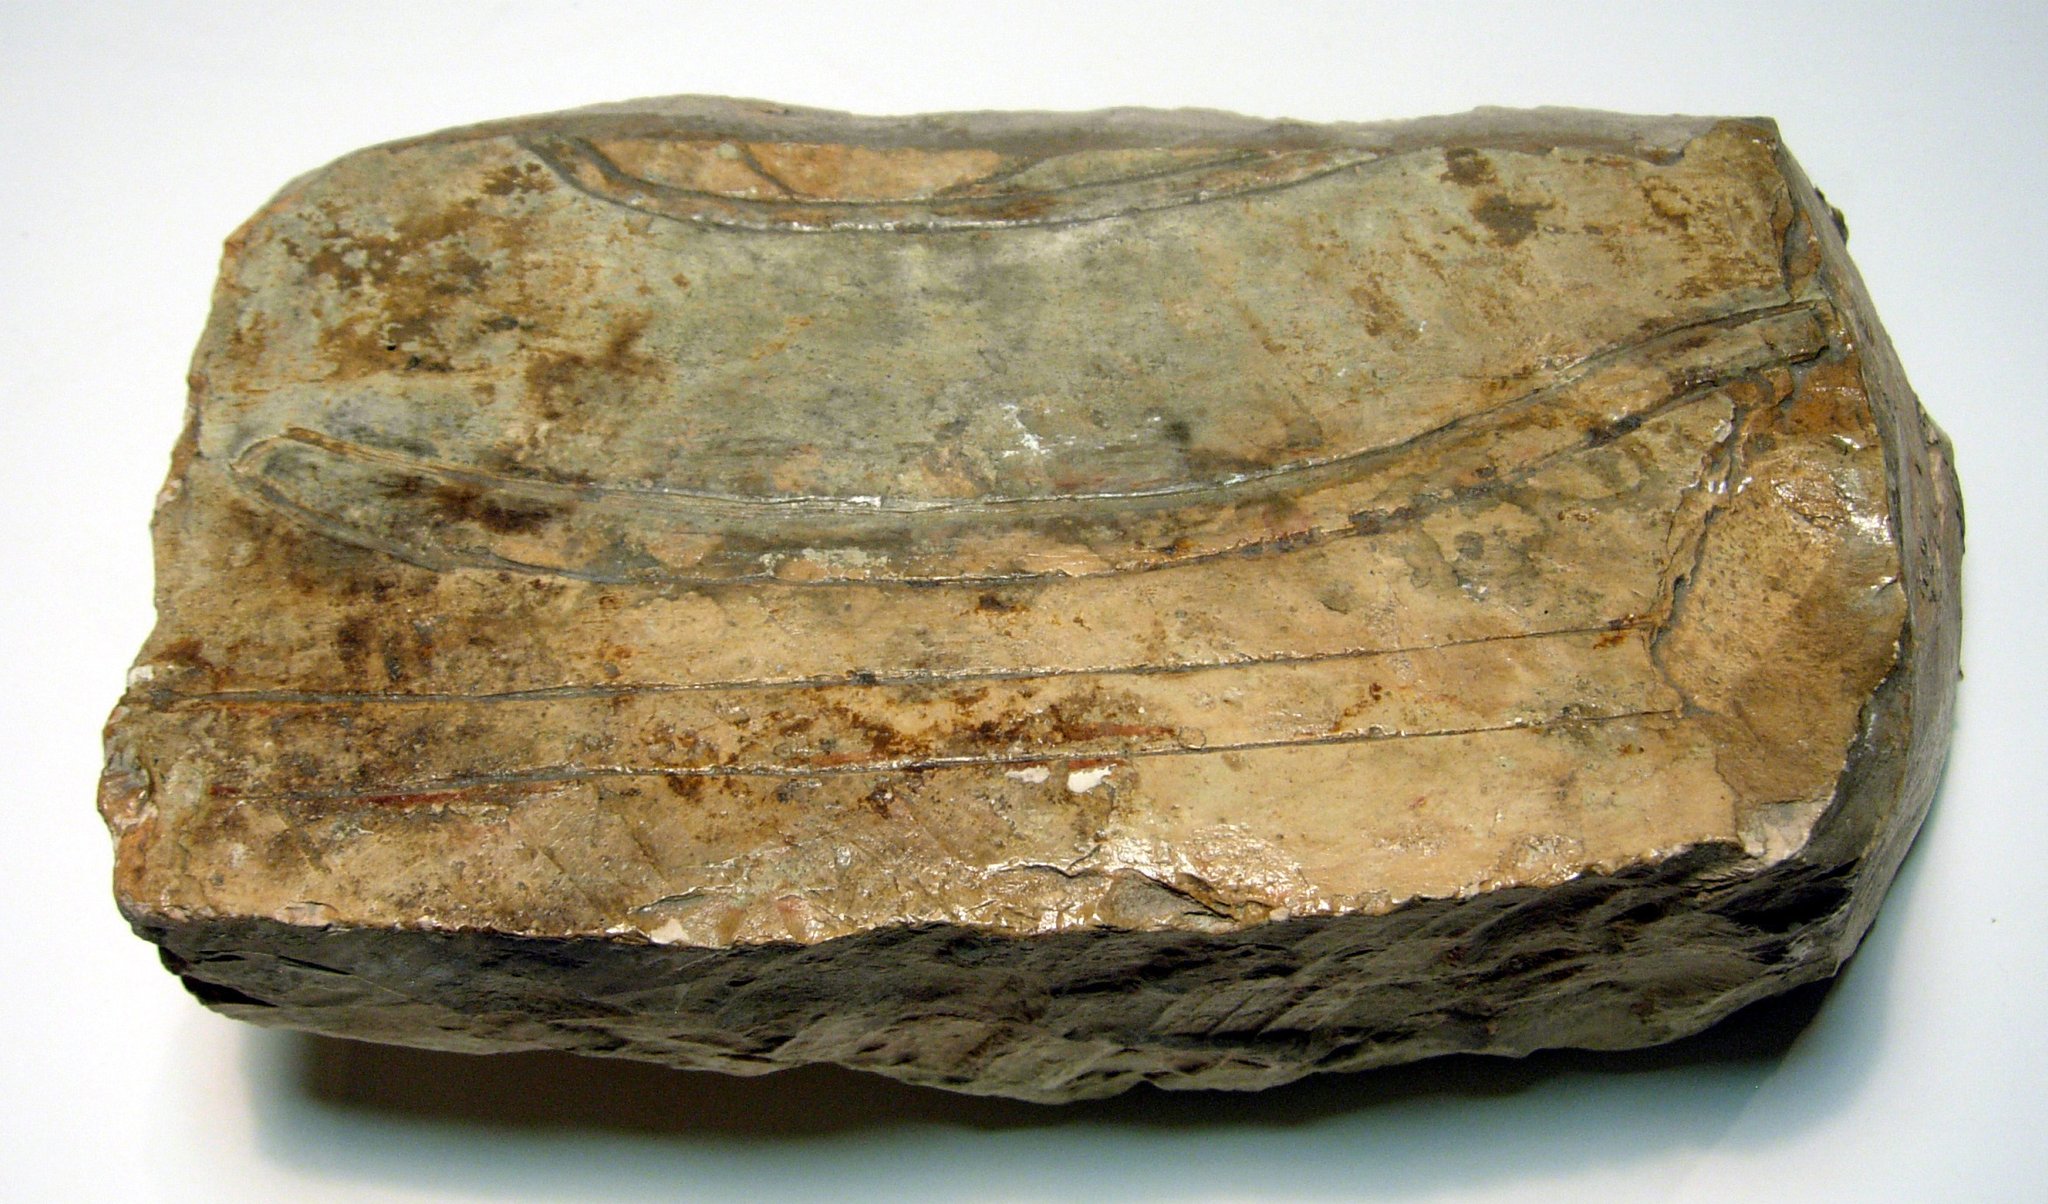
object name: relief, tomb of nespekashuty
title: Sunk relief fragment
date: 664-610 BCE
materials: limestone, varnish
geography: egypt